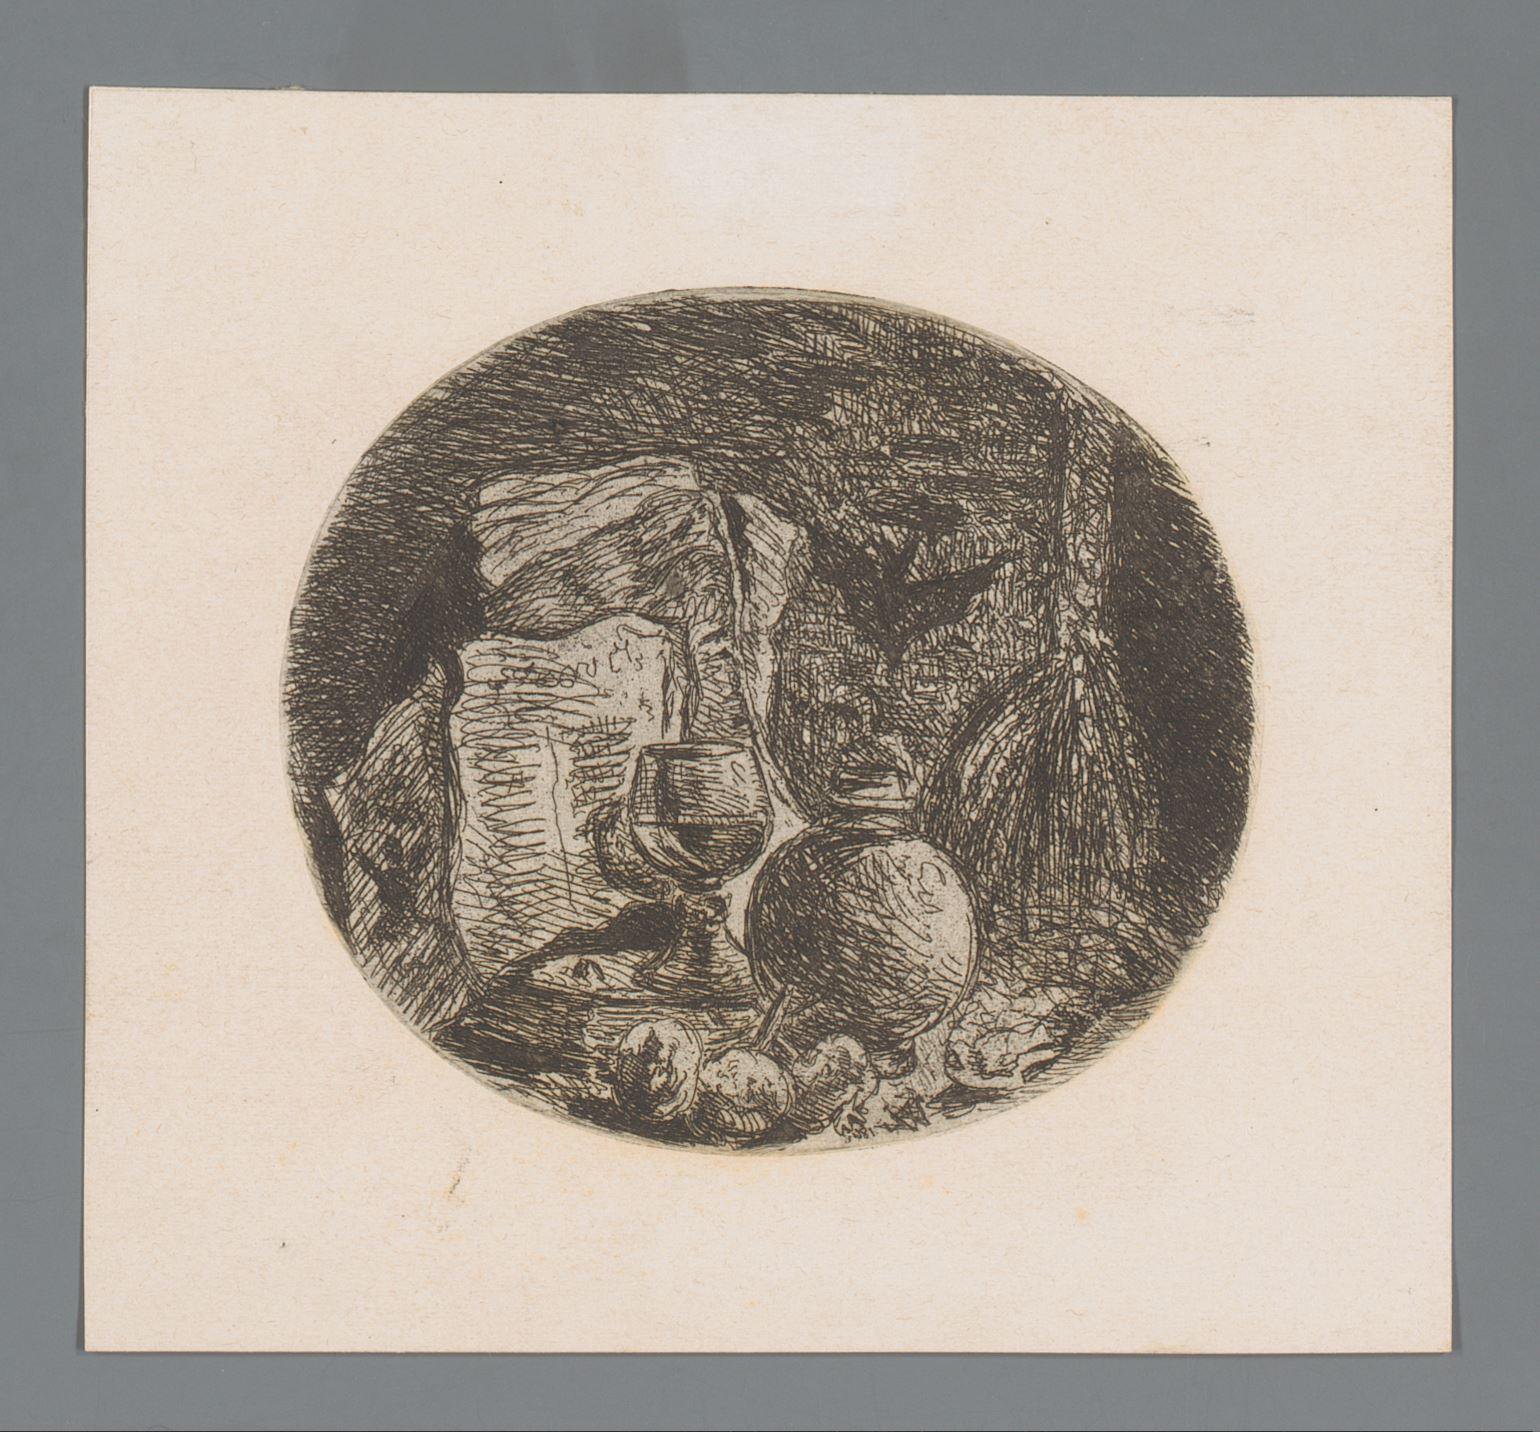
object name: print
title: Stilleven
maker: willem linnig (ii)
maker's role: print maker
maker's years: 1842-1890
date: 1852-1868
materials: paper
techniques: etching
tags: still life of miscellaneous objects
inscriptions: collector's mark: Lugt 2228, collector's mark: Lugt 1485